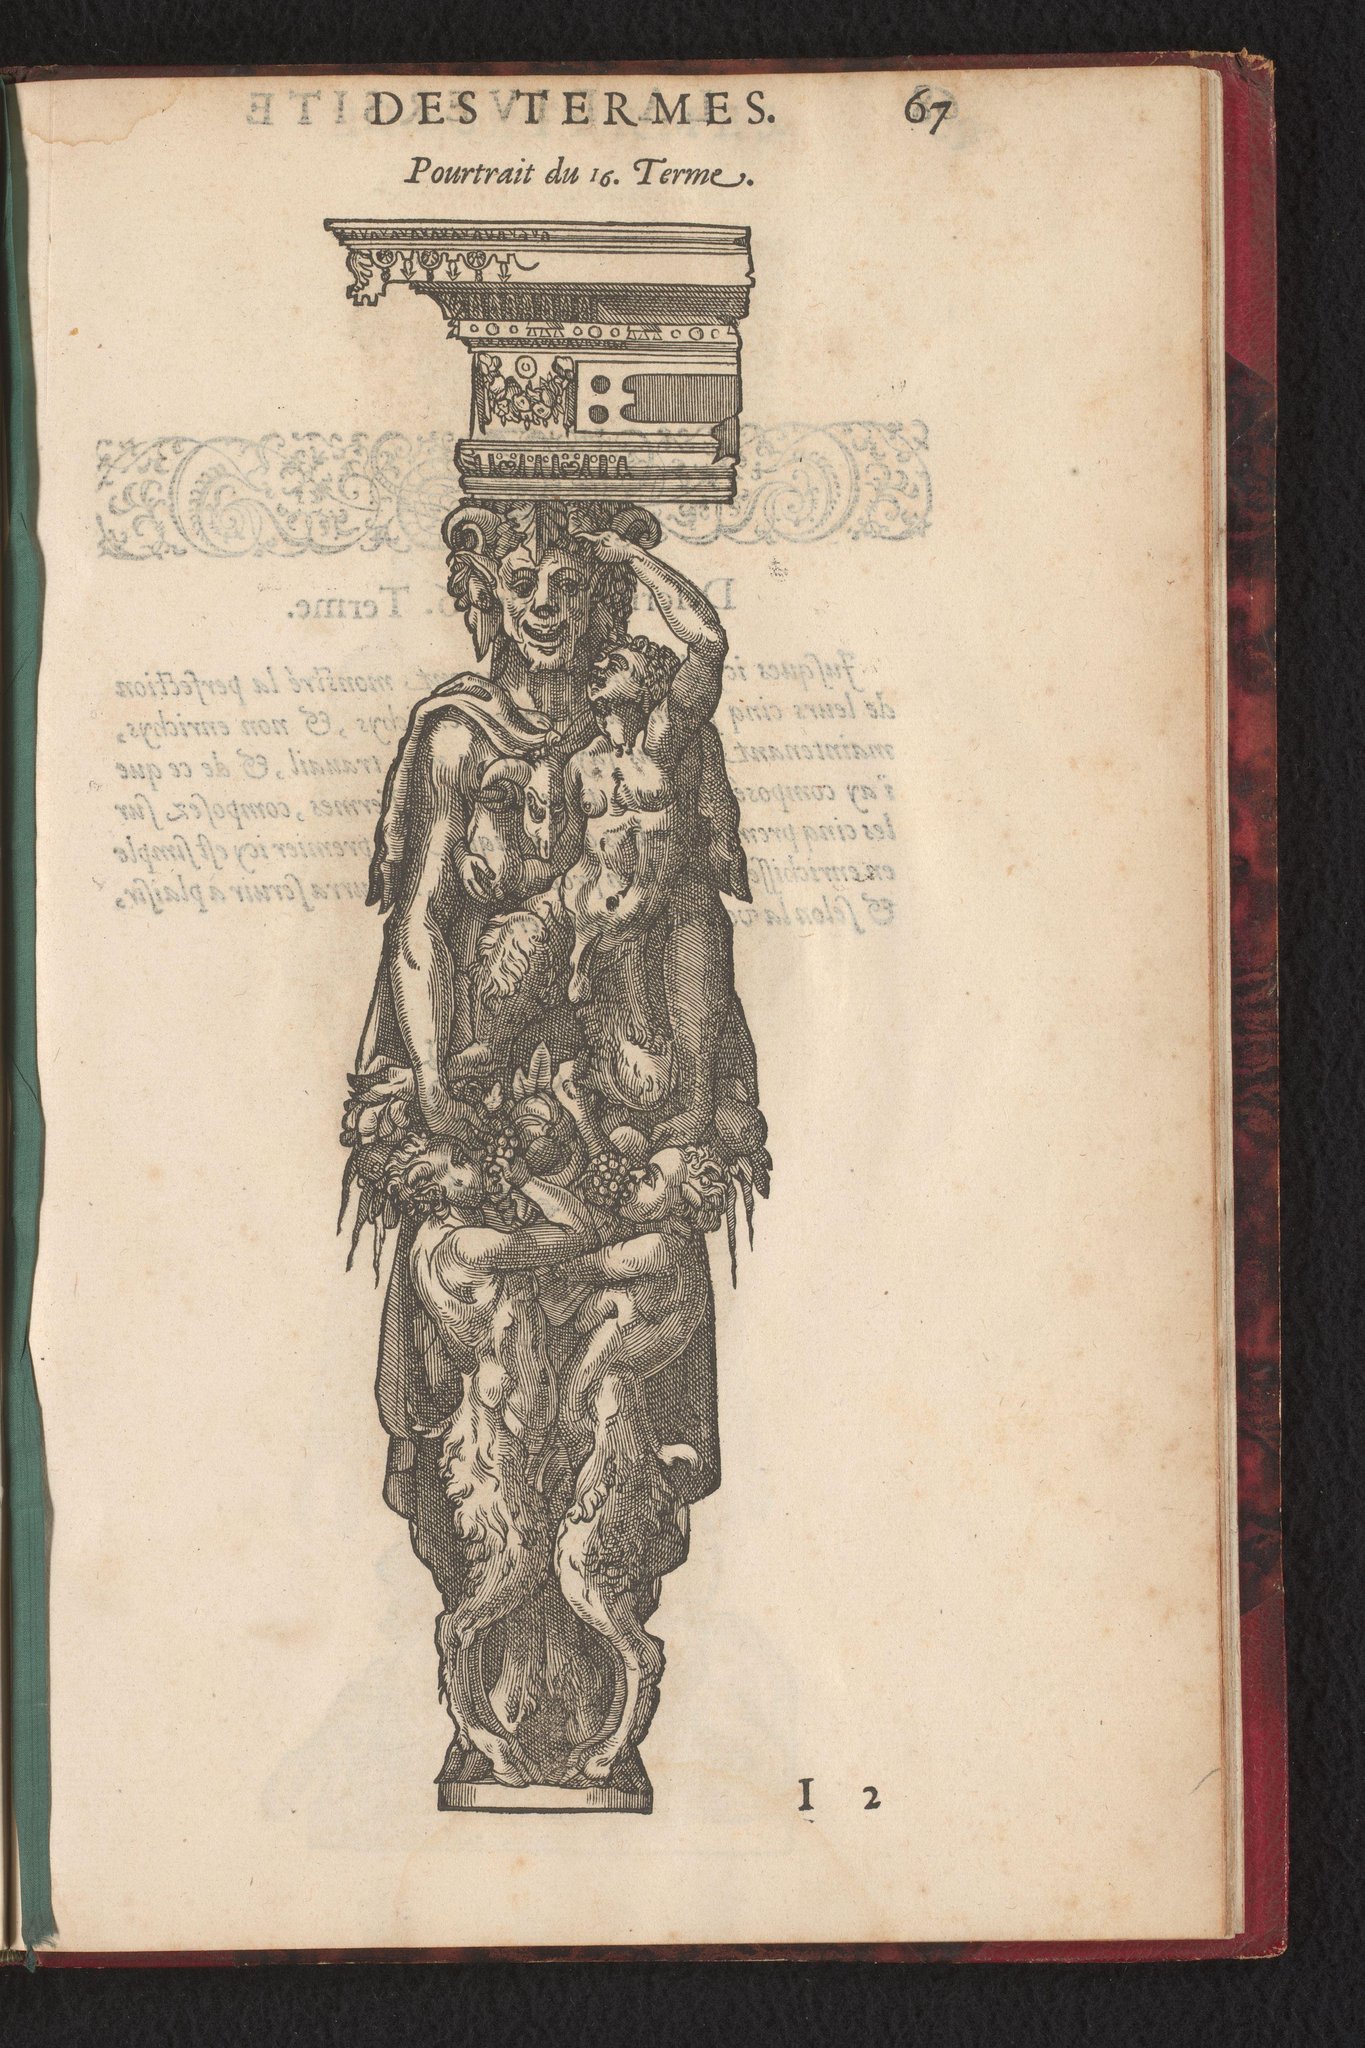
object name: album leaf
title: Termen in verschillende architectonische orden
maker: Anonymous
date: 1572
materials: paper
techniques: letterpress printing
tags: herms (garden ornaments), pedestal of a piece of sculpture (perhaps in the form of a herm), satyr(s) (in general), herm: pillar with the head of mercury, patron of travellers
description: Rond de sater nog drie kleine saters. Rechtsboven genummerd: 67. Rechtsonder genummerd: I 2. Volgens de toelichting op pagina 68 gaat het hier om een combinatie van de Dorische, Ionische, Korintische en Composiete orde. Prent maakt deel uit van een album.